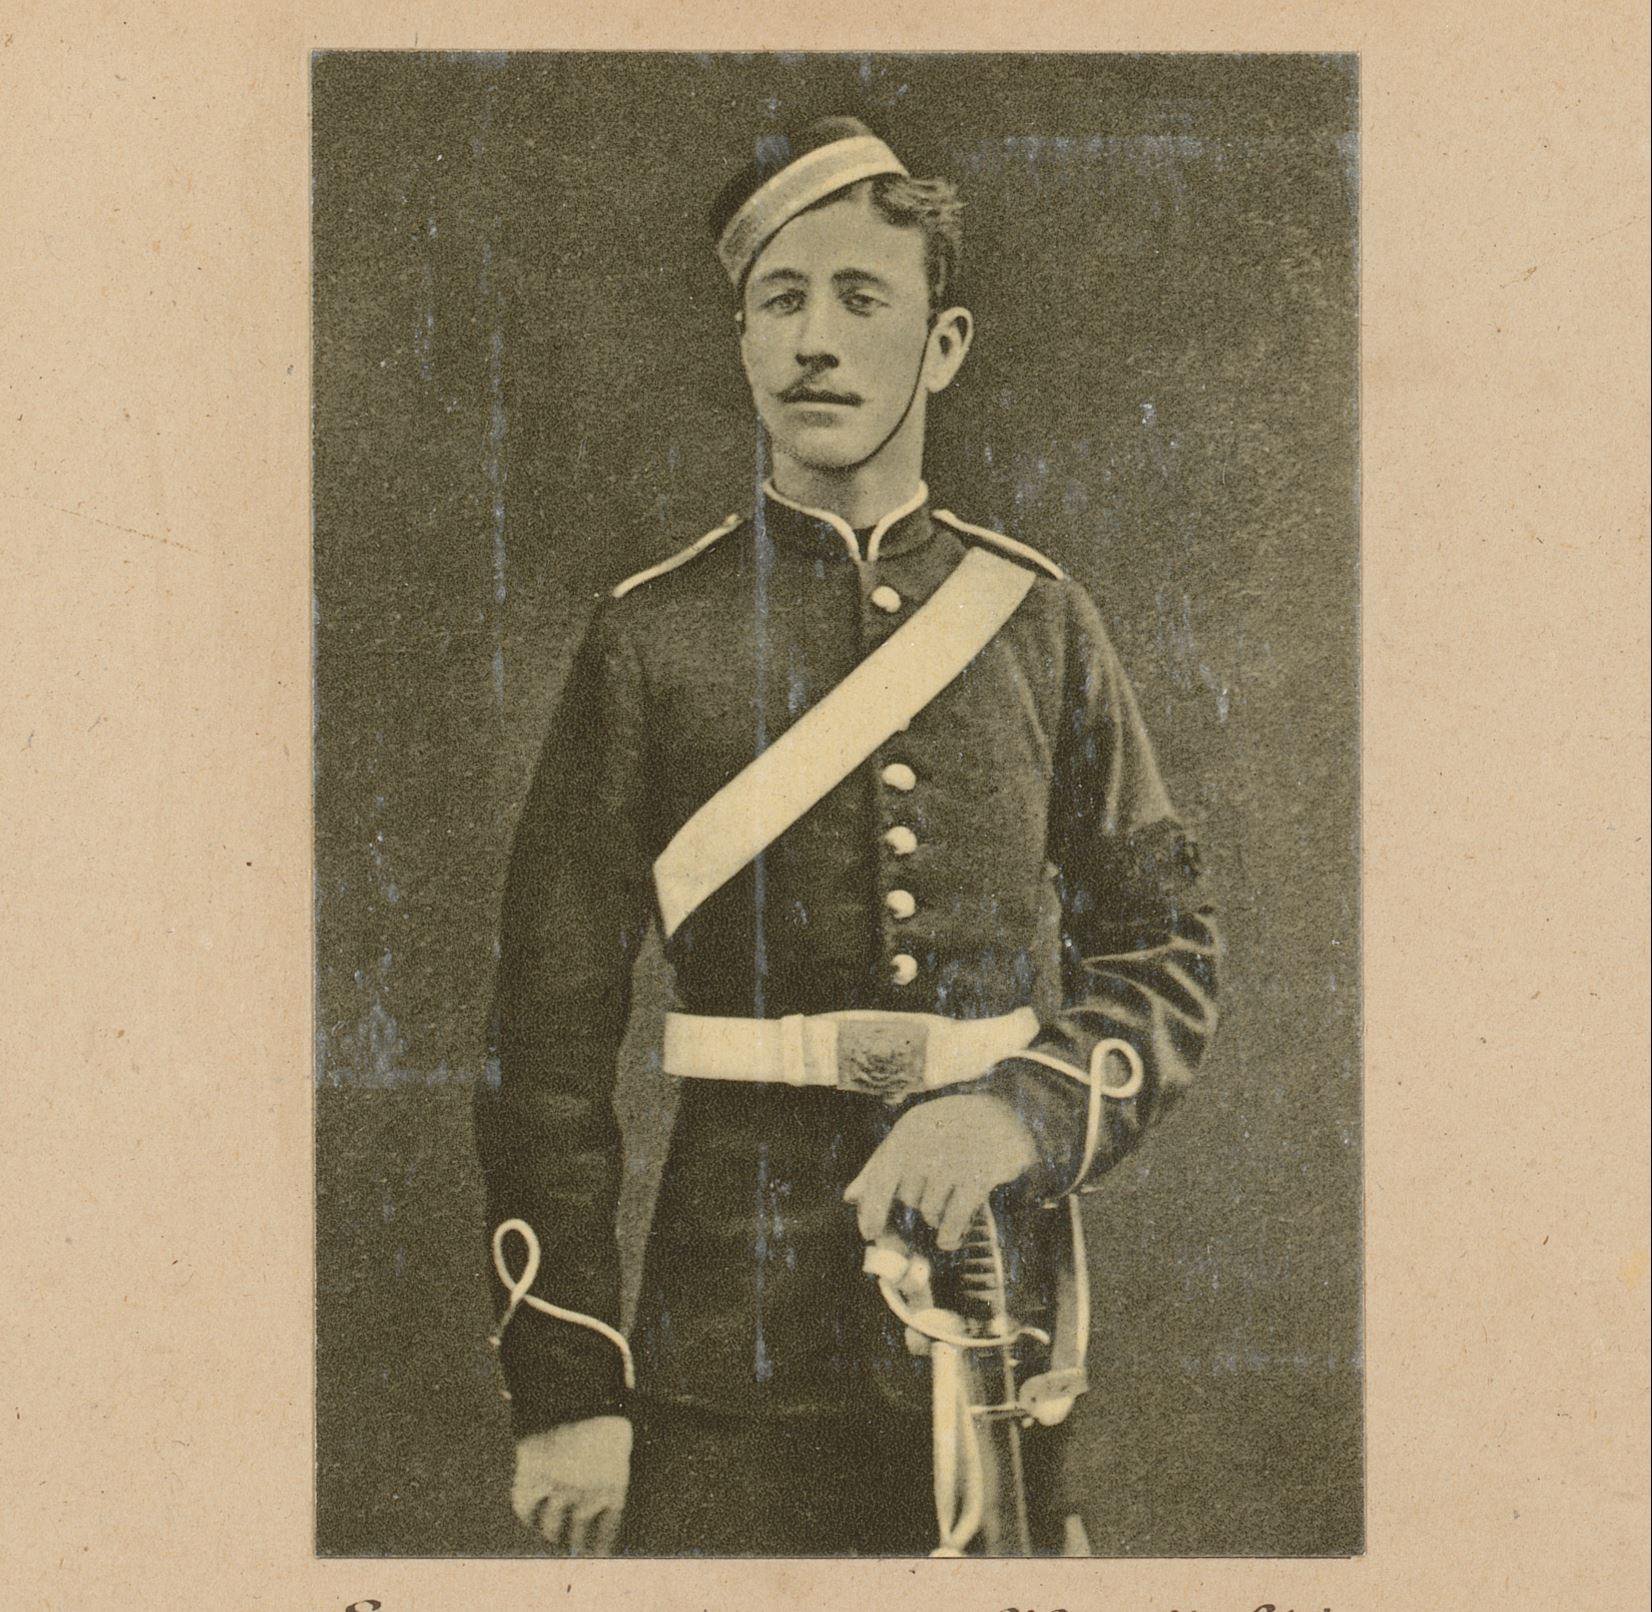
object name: photograph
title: Portret van Napoleon Eugène Lodewijk Bonaparte in militair uniform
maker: Anonymous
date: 1873-1879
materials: paper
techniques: rotogravure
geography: france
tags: paris, historical persons, emperor, france